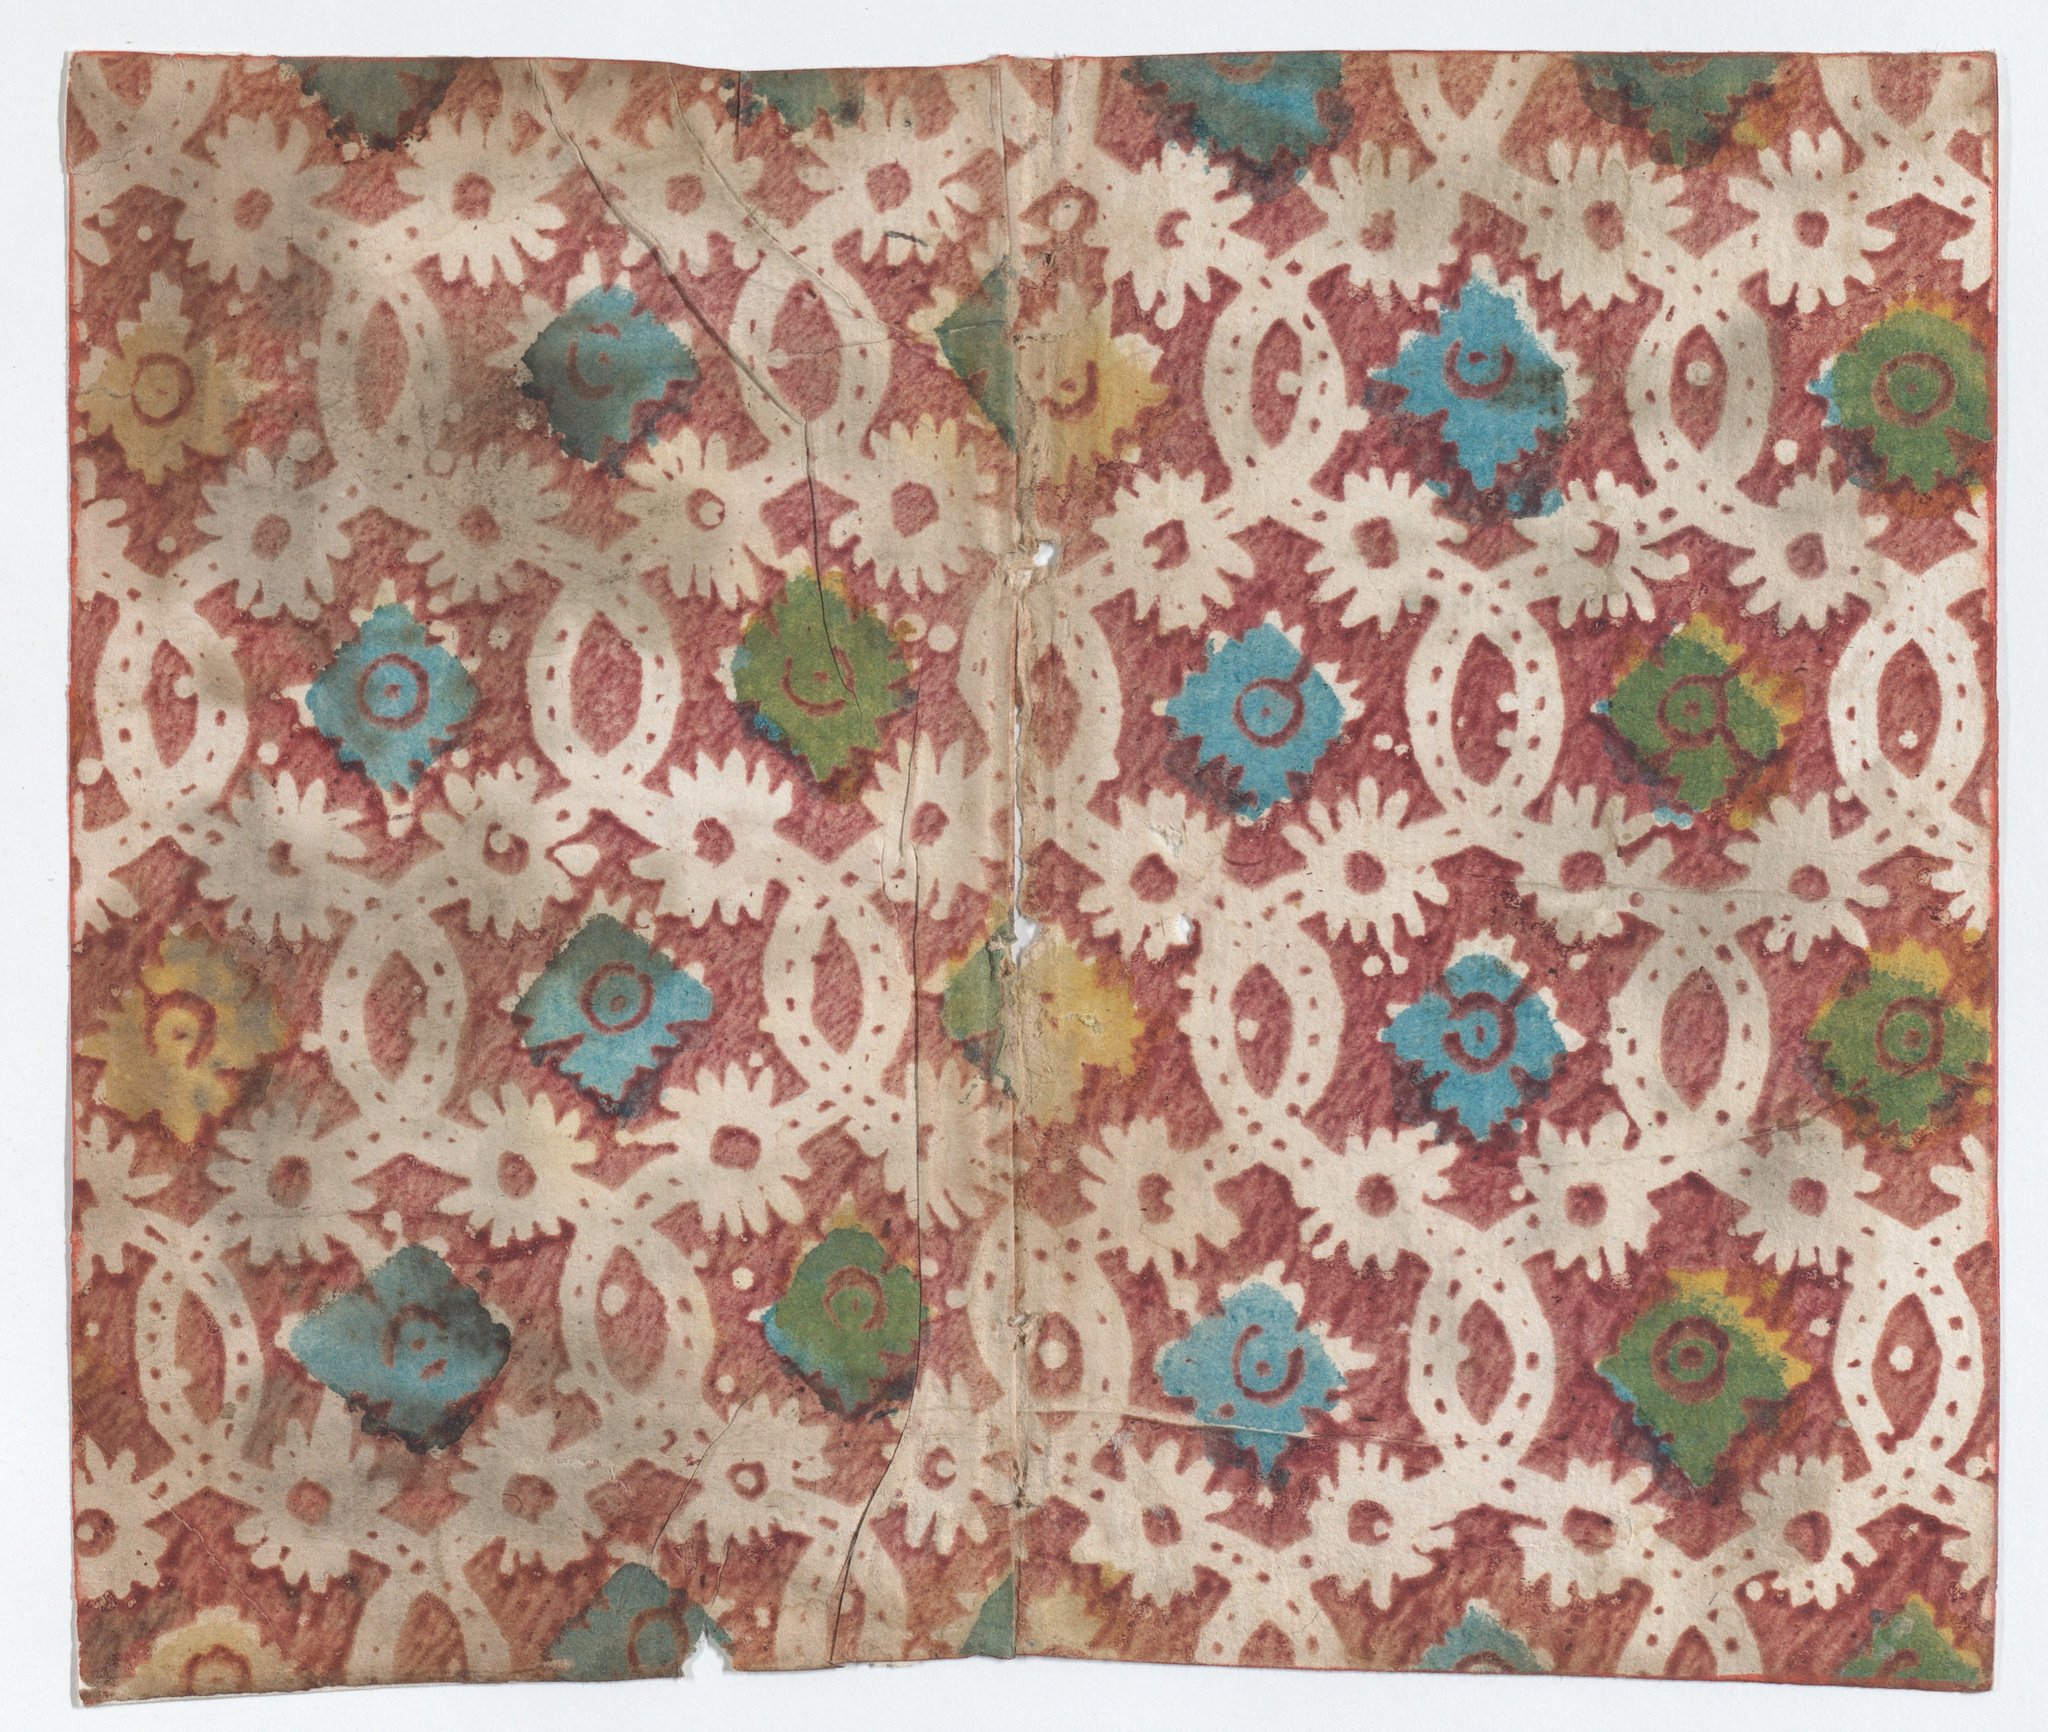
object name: print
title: Sheet with overall lattice pattern with rosettes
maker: Anonymous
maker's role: artist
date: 1801-1900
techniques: relief print